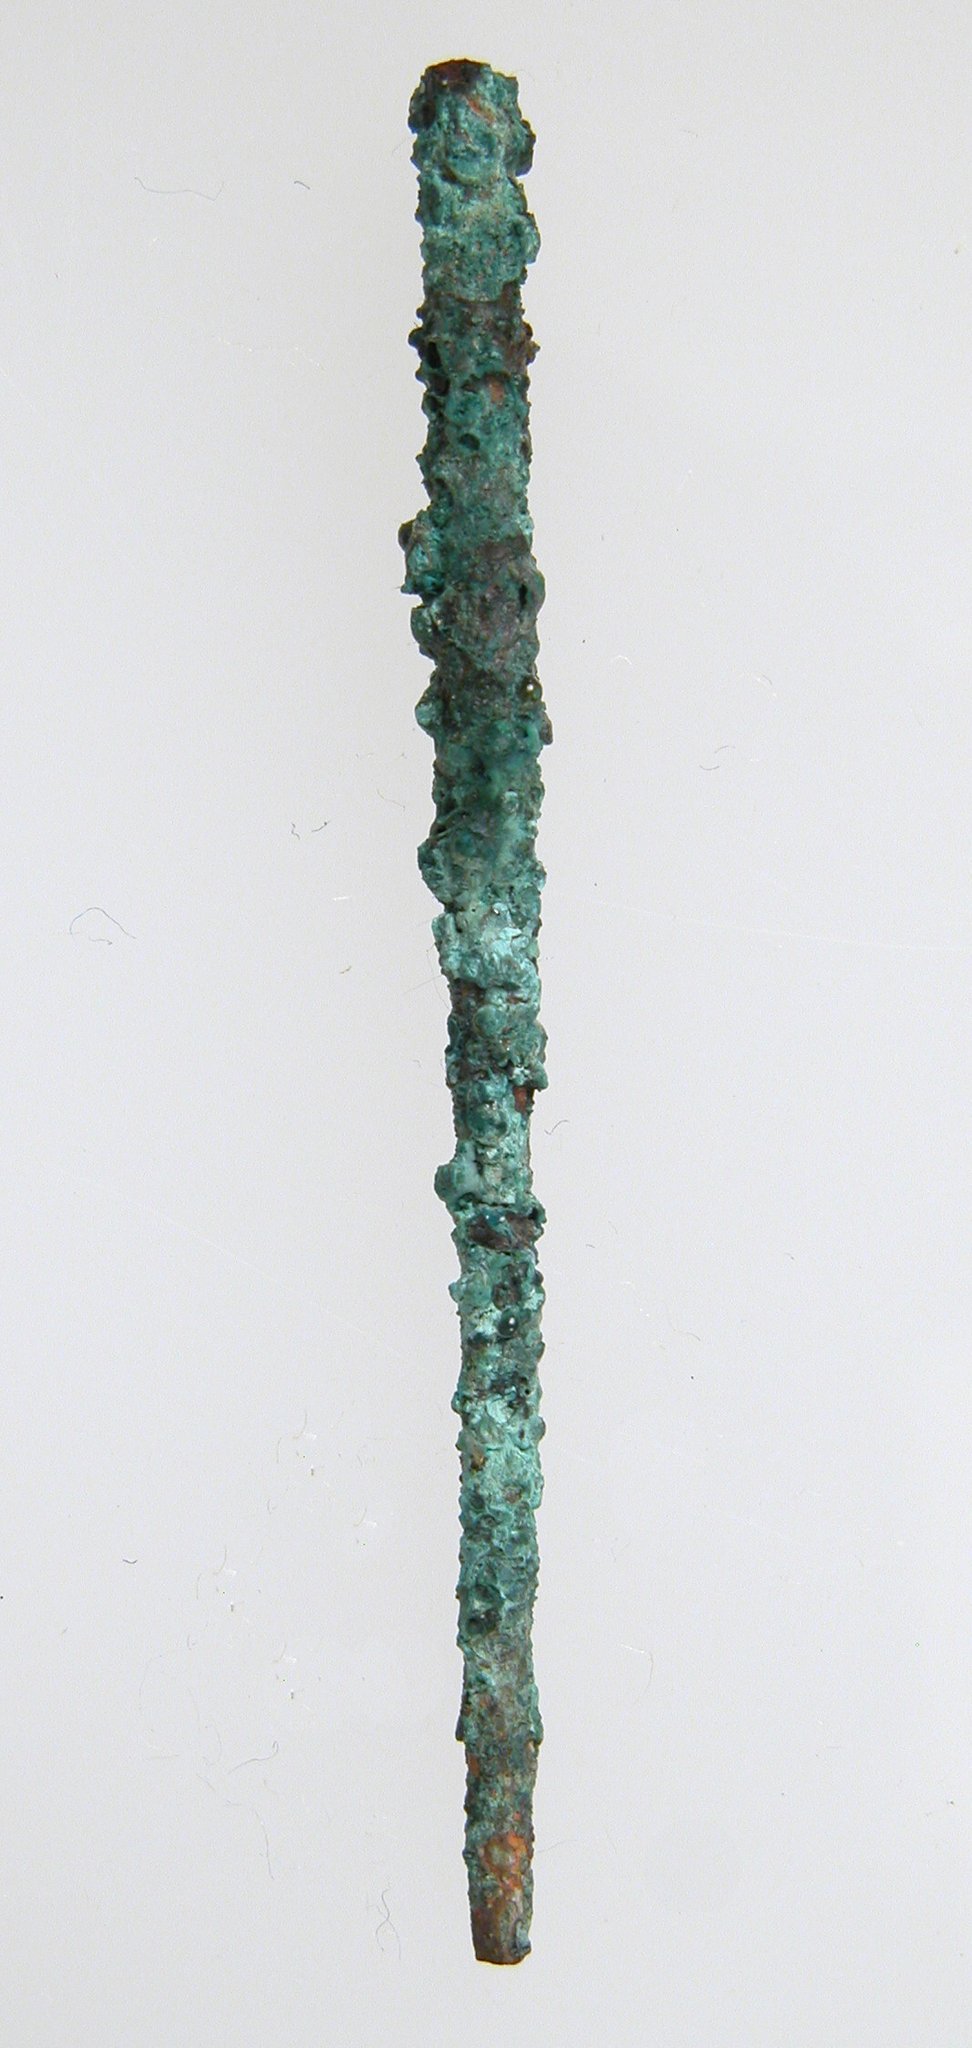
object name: pin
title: Pin Part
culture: roman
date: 200-500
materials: copper alloy